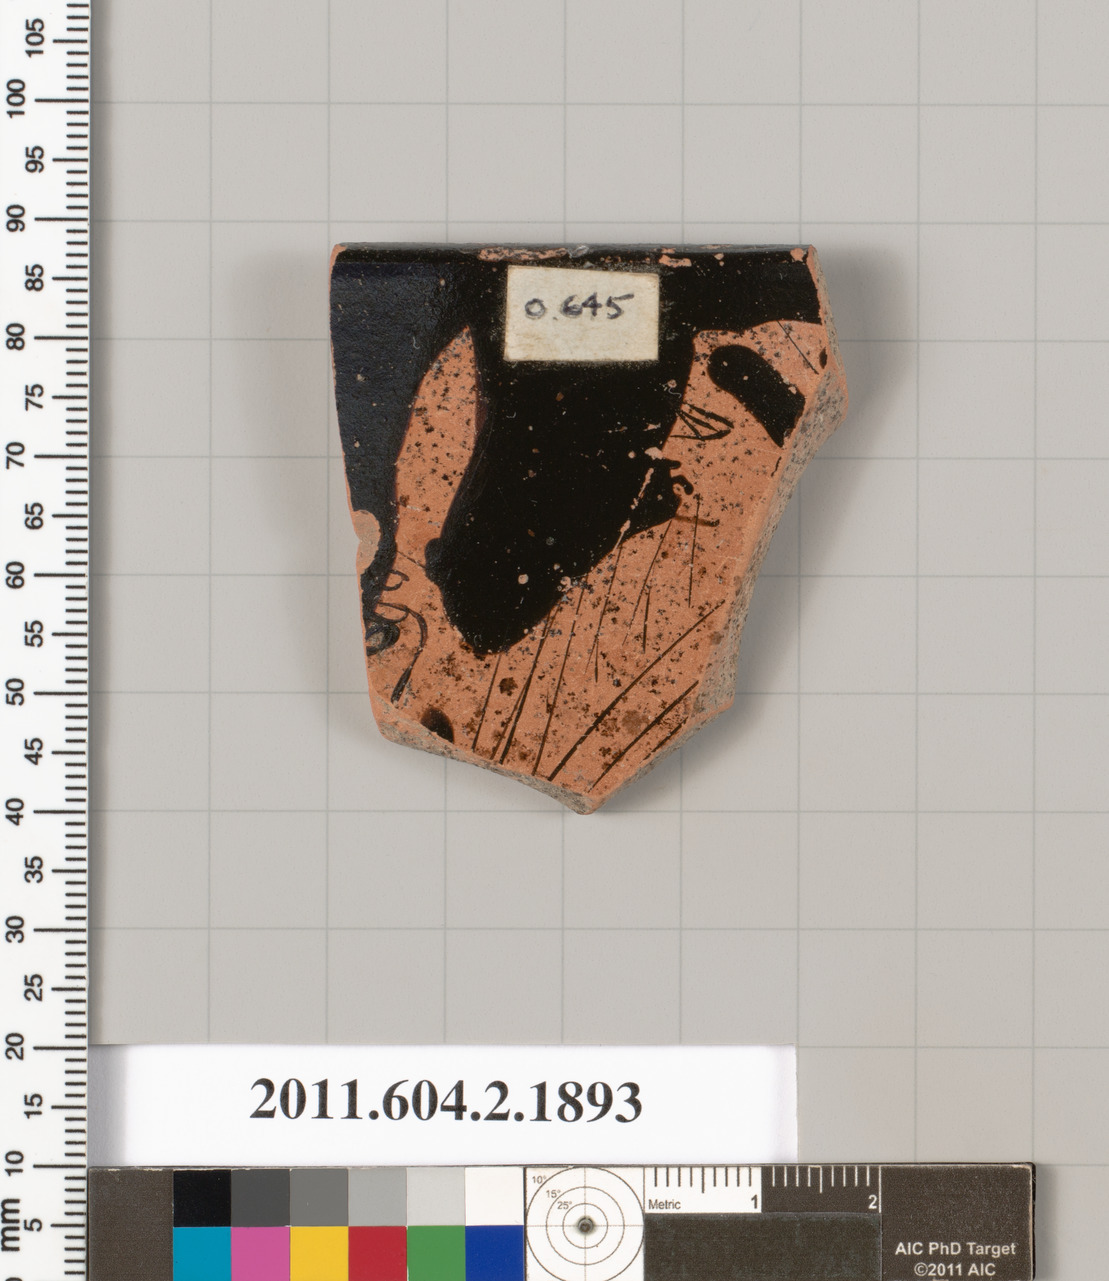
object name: skyphos fragment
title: Terracotta rim fragment of a skyphos (deep drinking cup)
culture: greek, attic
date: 425-401 BCE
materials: terracotta